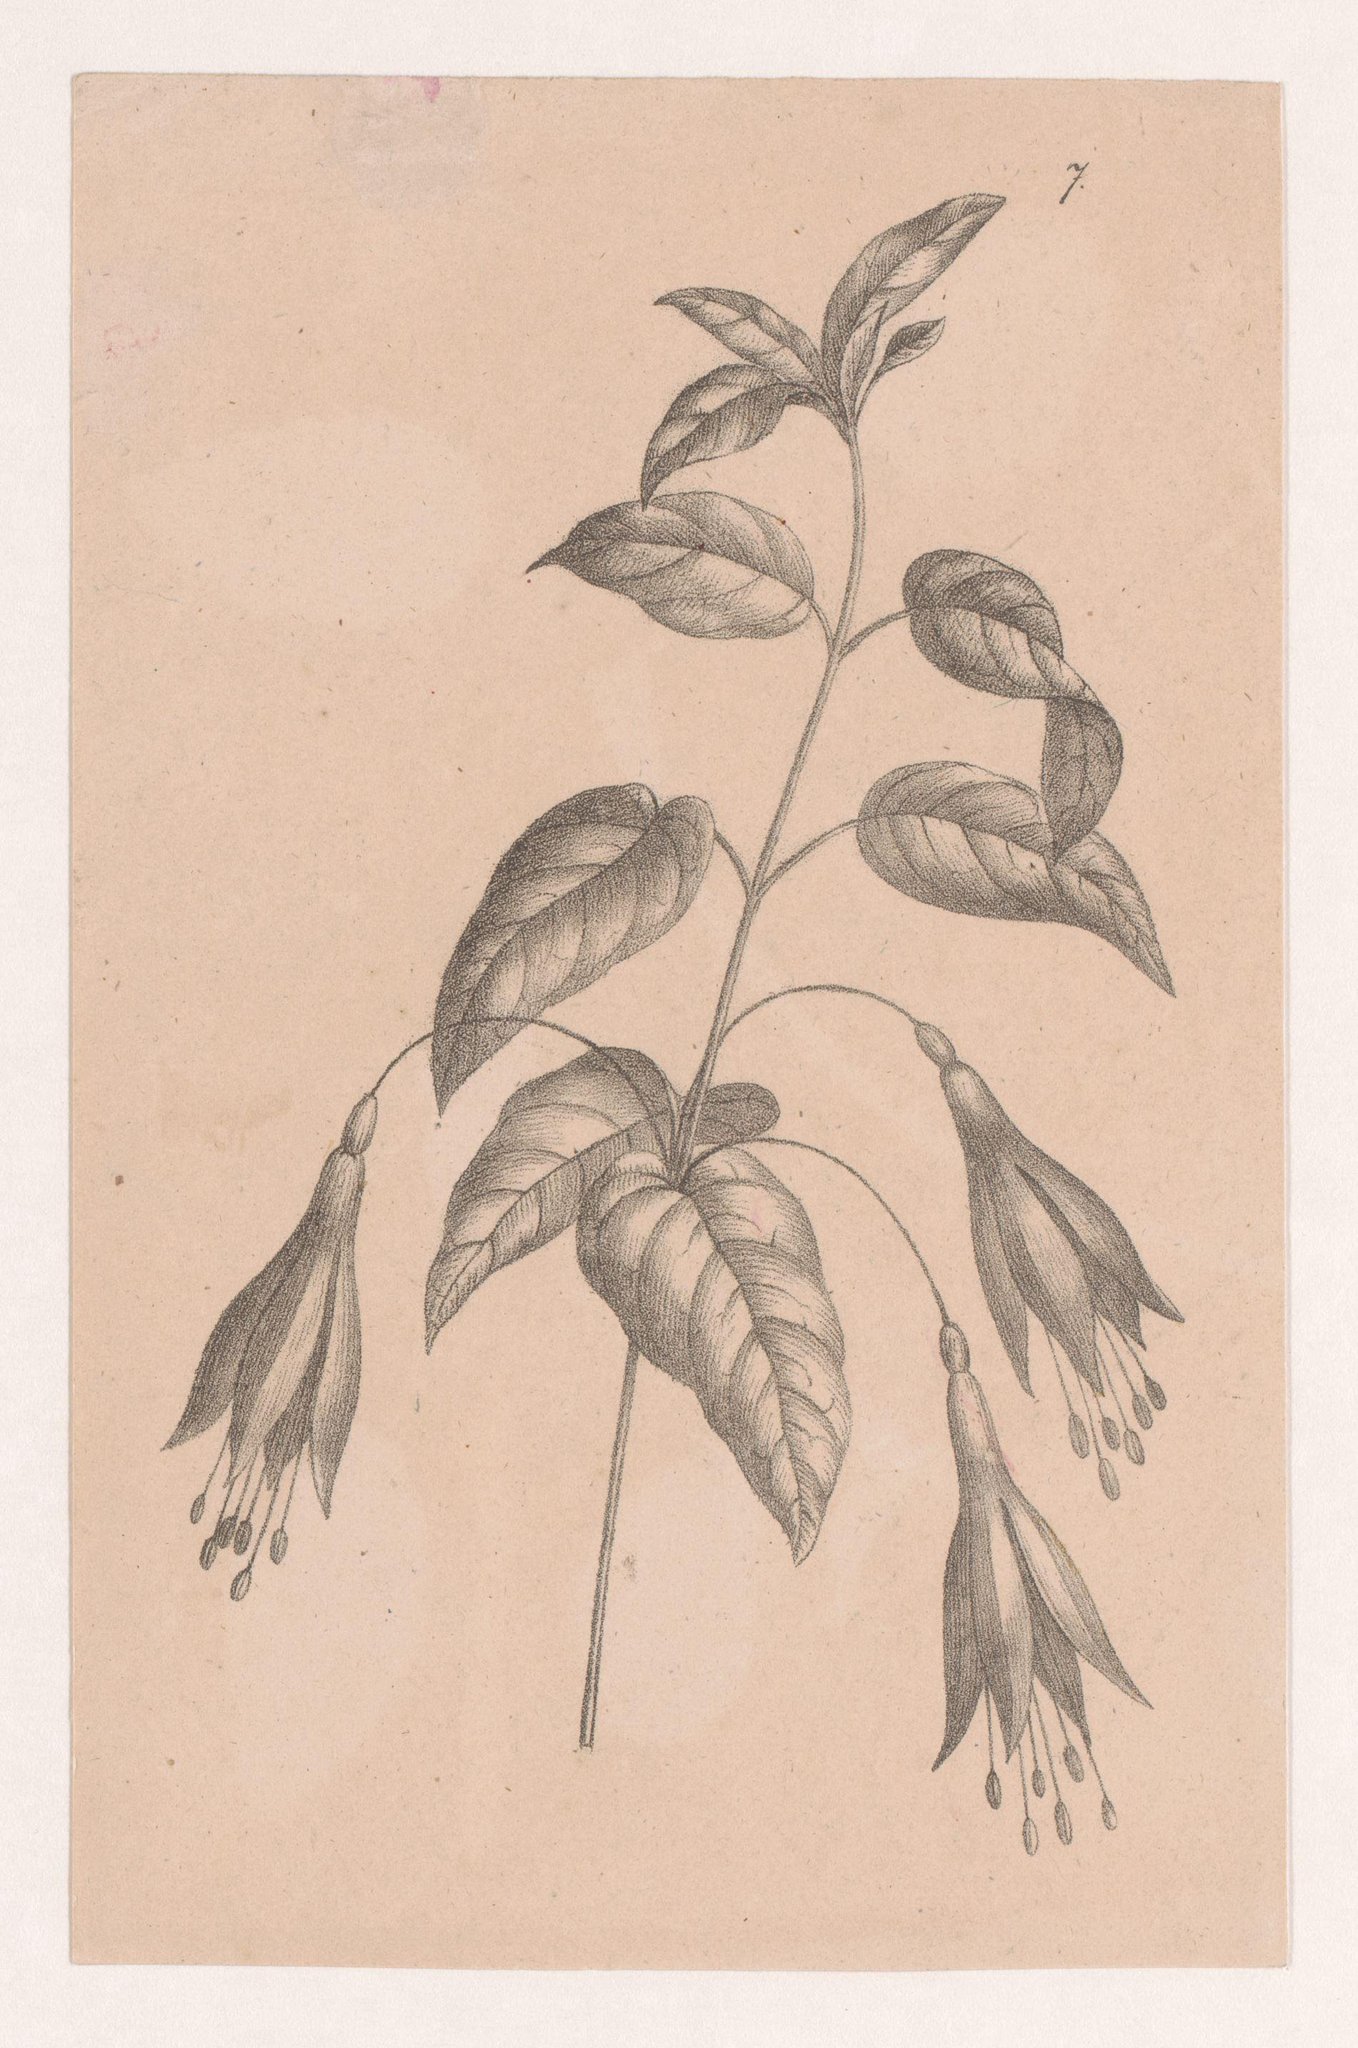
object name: print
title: Tak met bloemen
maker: maria geertruida de goeje-barbiers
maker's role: print maker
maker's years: 1801-1879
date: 1811-1849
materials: paper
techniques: lithograph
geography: haarlem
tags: cut flowers; nosegay, bunch of flowers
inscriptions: inscription: ‘voxia / klokjes donkerrood / het binnenste geel / bladen blauwachtig groen’, collector's mark: Lugt 2228